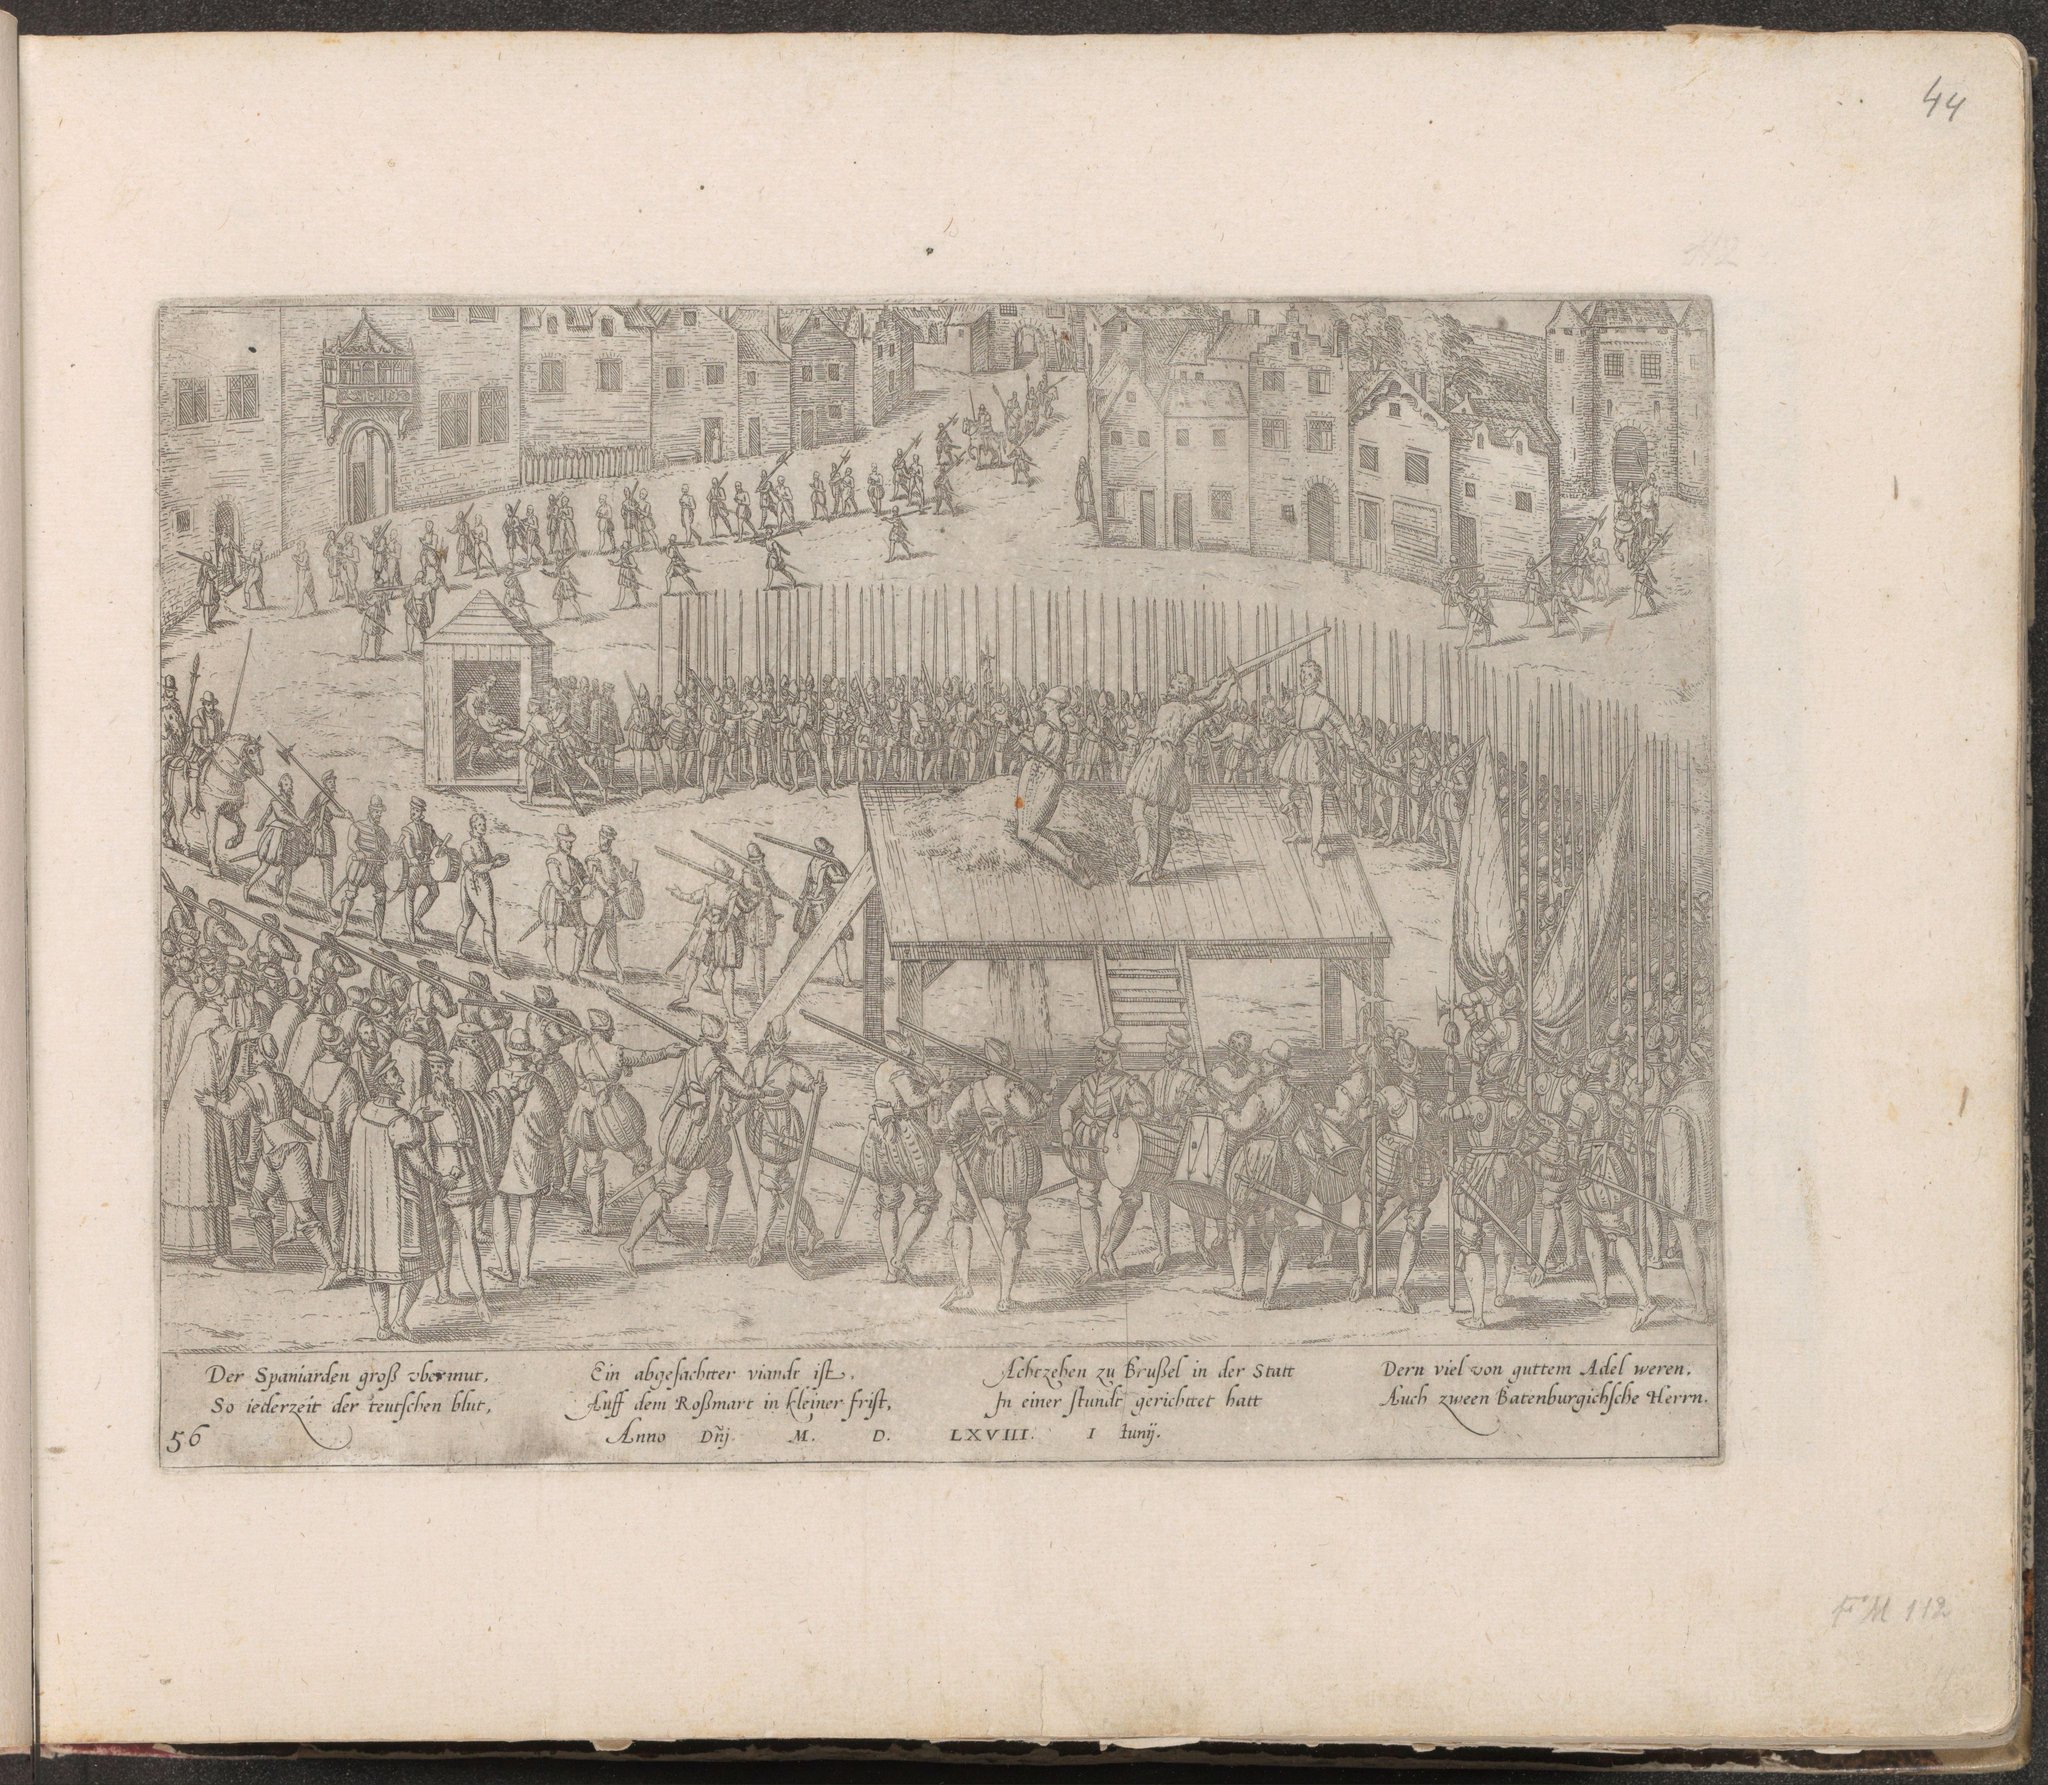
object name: album leaf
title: Achttien edelen te Brussel onthoofd, 1568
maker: frans hogenberg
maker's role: print maker, publisher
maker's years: 1538-1590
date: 1568-1572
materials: paper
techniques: etching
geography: cologne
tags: on the scaffold or place of execution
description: De onthoofding van achttien edelen, onder wie de twee gebroeders van Batenburg, op een schavot op de Paardenmarkt te Brussel, 1 juni 1568. Met onderschrift van 8 regels in het Duits. Linksonder genummerd: 56. De prent maakt deel uit van een album.